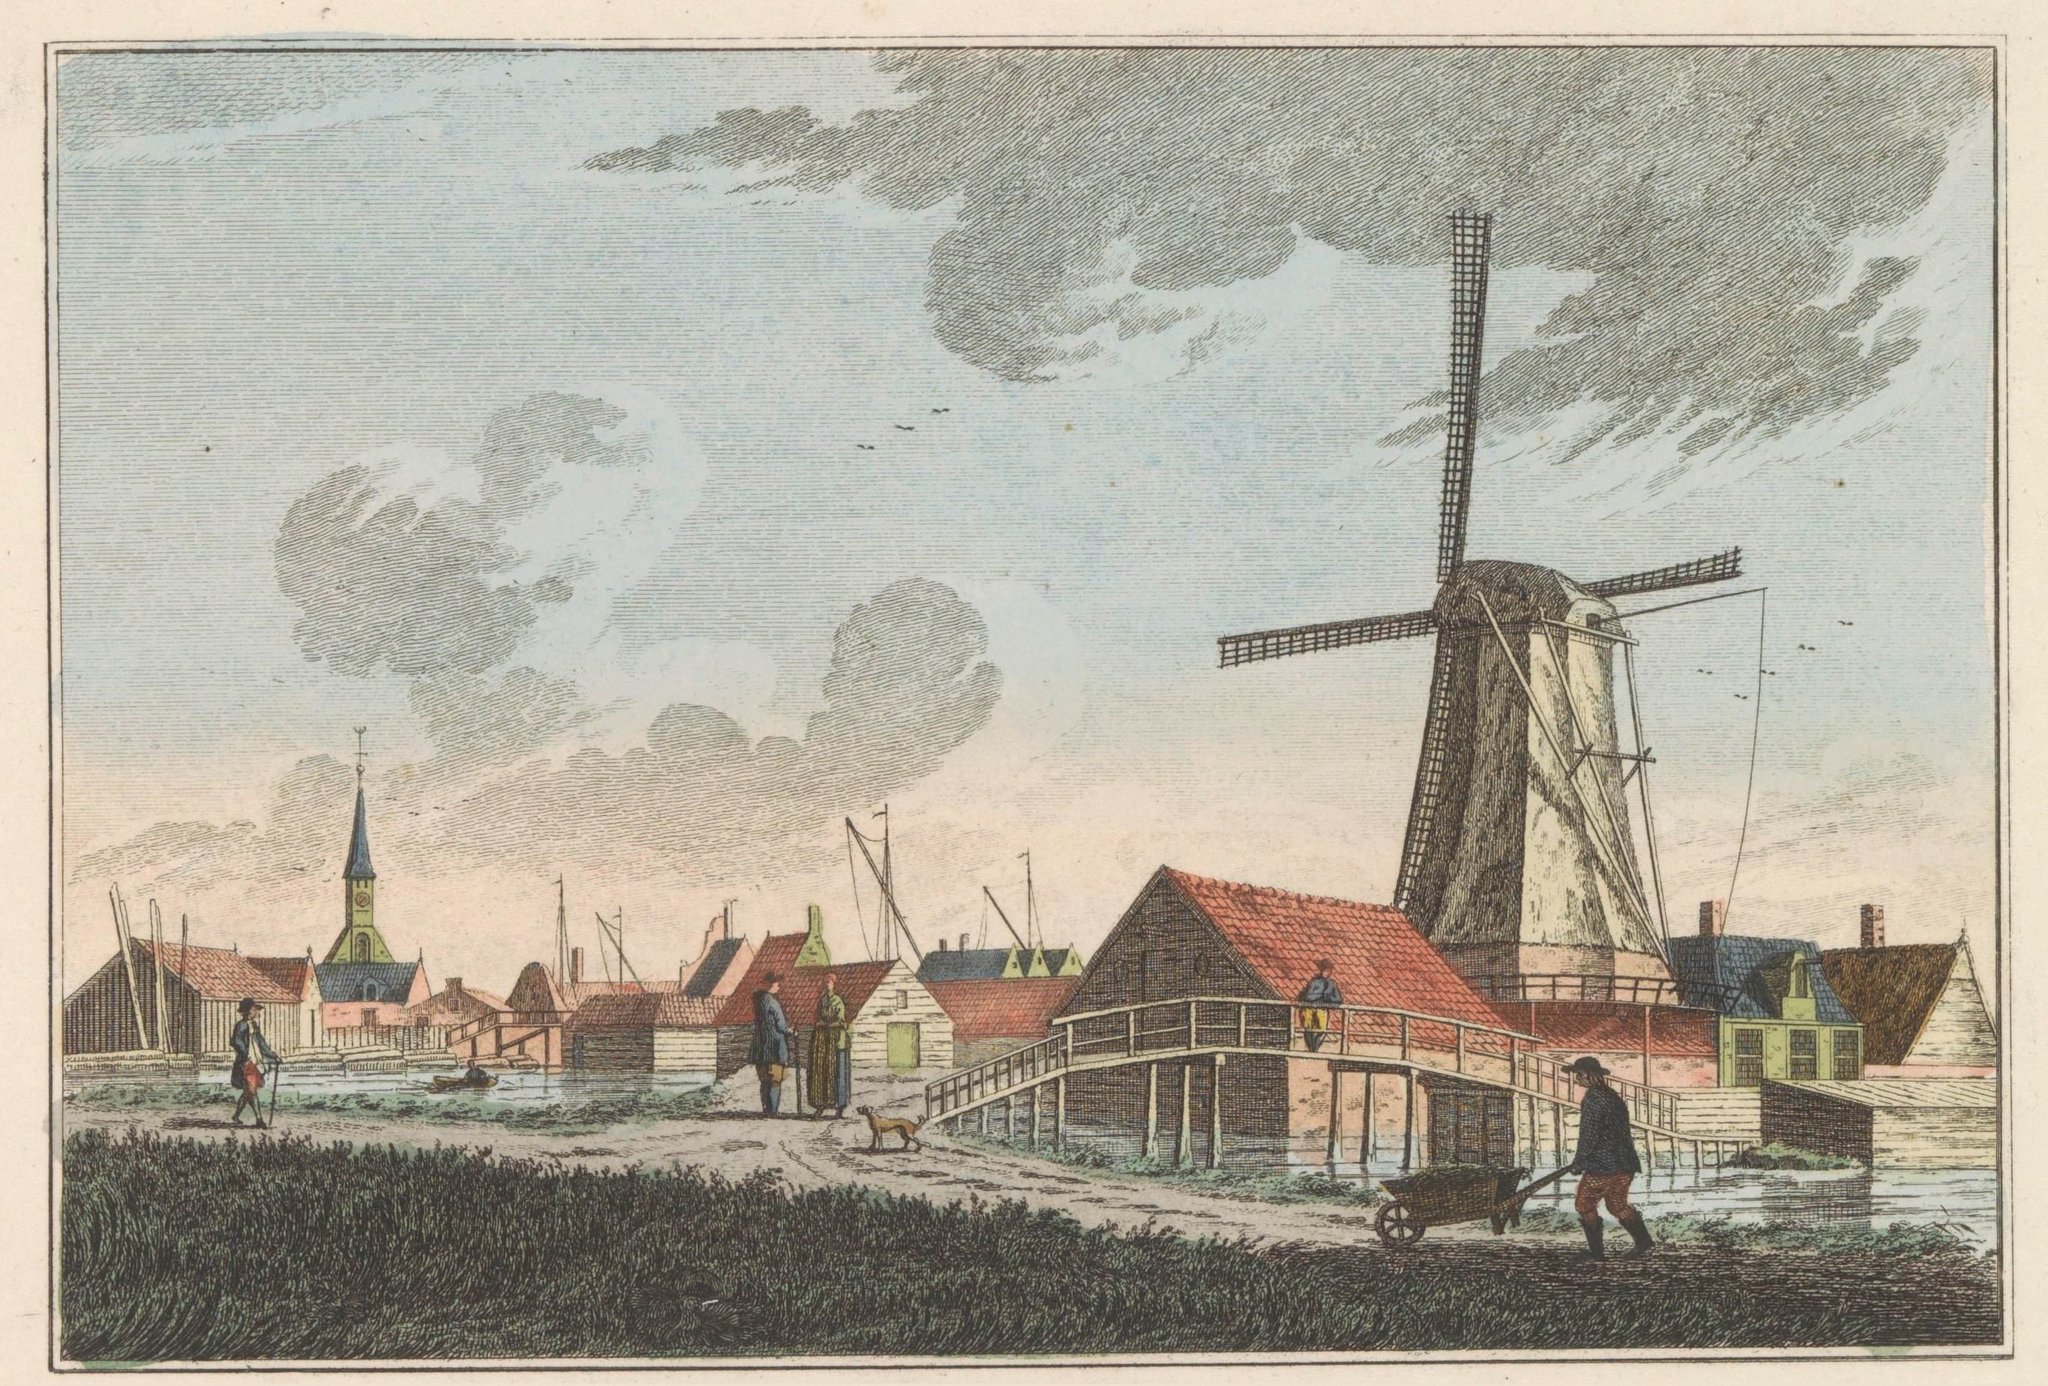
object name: print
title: Nieuwendam, ca. 1790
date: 1786-1792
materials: paper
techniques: engraving, etching, hand coloring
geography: amsterdam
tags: nieuwendam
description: Prent eerder gebruikt in: Vaderlandsche gezichten, of afbeeldingen van den tegenwoordigen staat der Vereenigde Nederlanden (…). Amsterdam: Hendrik Gartman, Willem Vermandel en Jan Willem Smit, 1786-1792. Uitgegeven in afleveringen met ieder een eigen bifolium en inhoudsopgave. Alle prenten in deze publicatie zijn gegraveerd door Carel Frederik Bendorp (I) en, in de meeste gevallen, gebaseerd op tekeningen van Jan Bulthuis. Dit exemplaar is later uitgegeven als onderdeel van een plaatwerk uit ca. 1824-1825 met 74 (ongenummerde) platen van de belangrijkste topografische gezichten en verschillende zeden en gewoonten in het Verenigd Koninkrijk der Nederlanden, getiteld 'Tableau des principales vues des palais et édifices : représentations et des coutumes et usages, dans les provinces septentrionales du Royaume des Pays-Bas'. Bij de andere prenten uit 'Vaderlandsche gezichten' die zijn hergebruikt voor dit plaatwerk is een tweede Franse titel toegevoegd, waardoor er sprake is van twee verschillende staten. Het is onduidelijk of dat voor deze prent ook geldt.